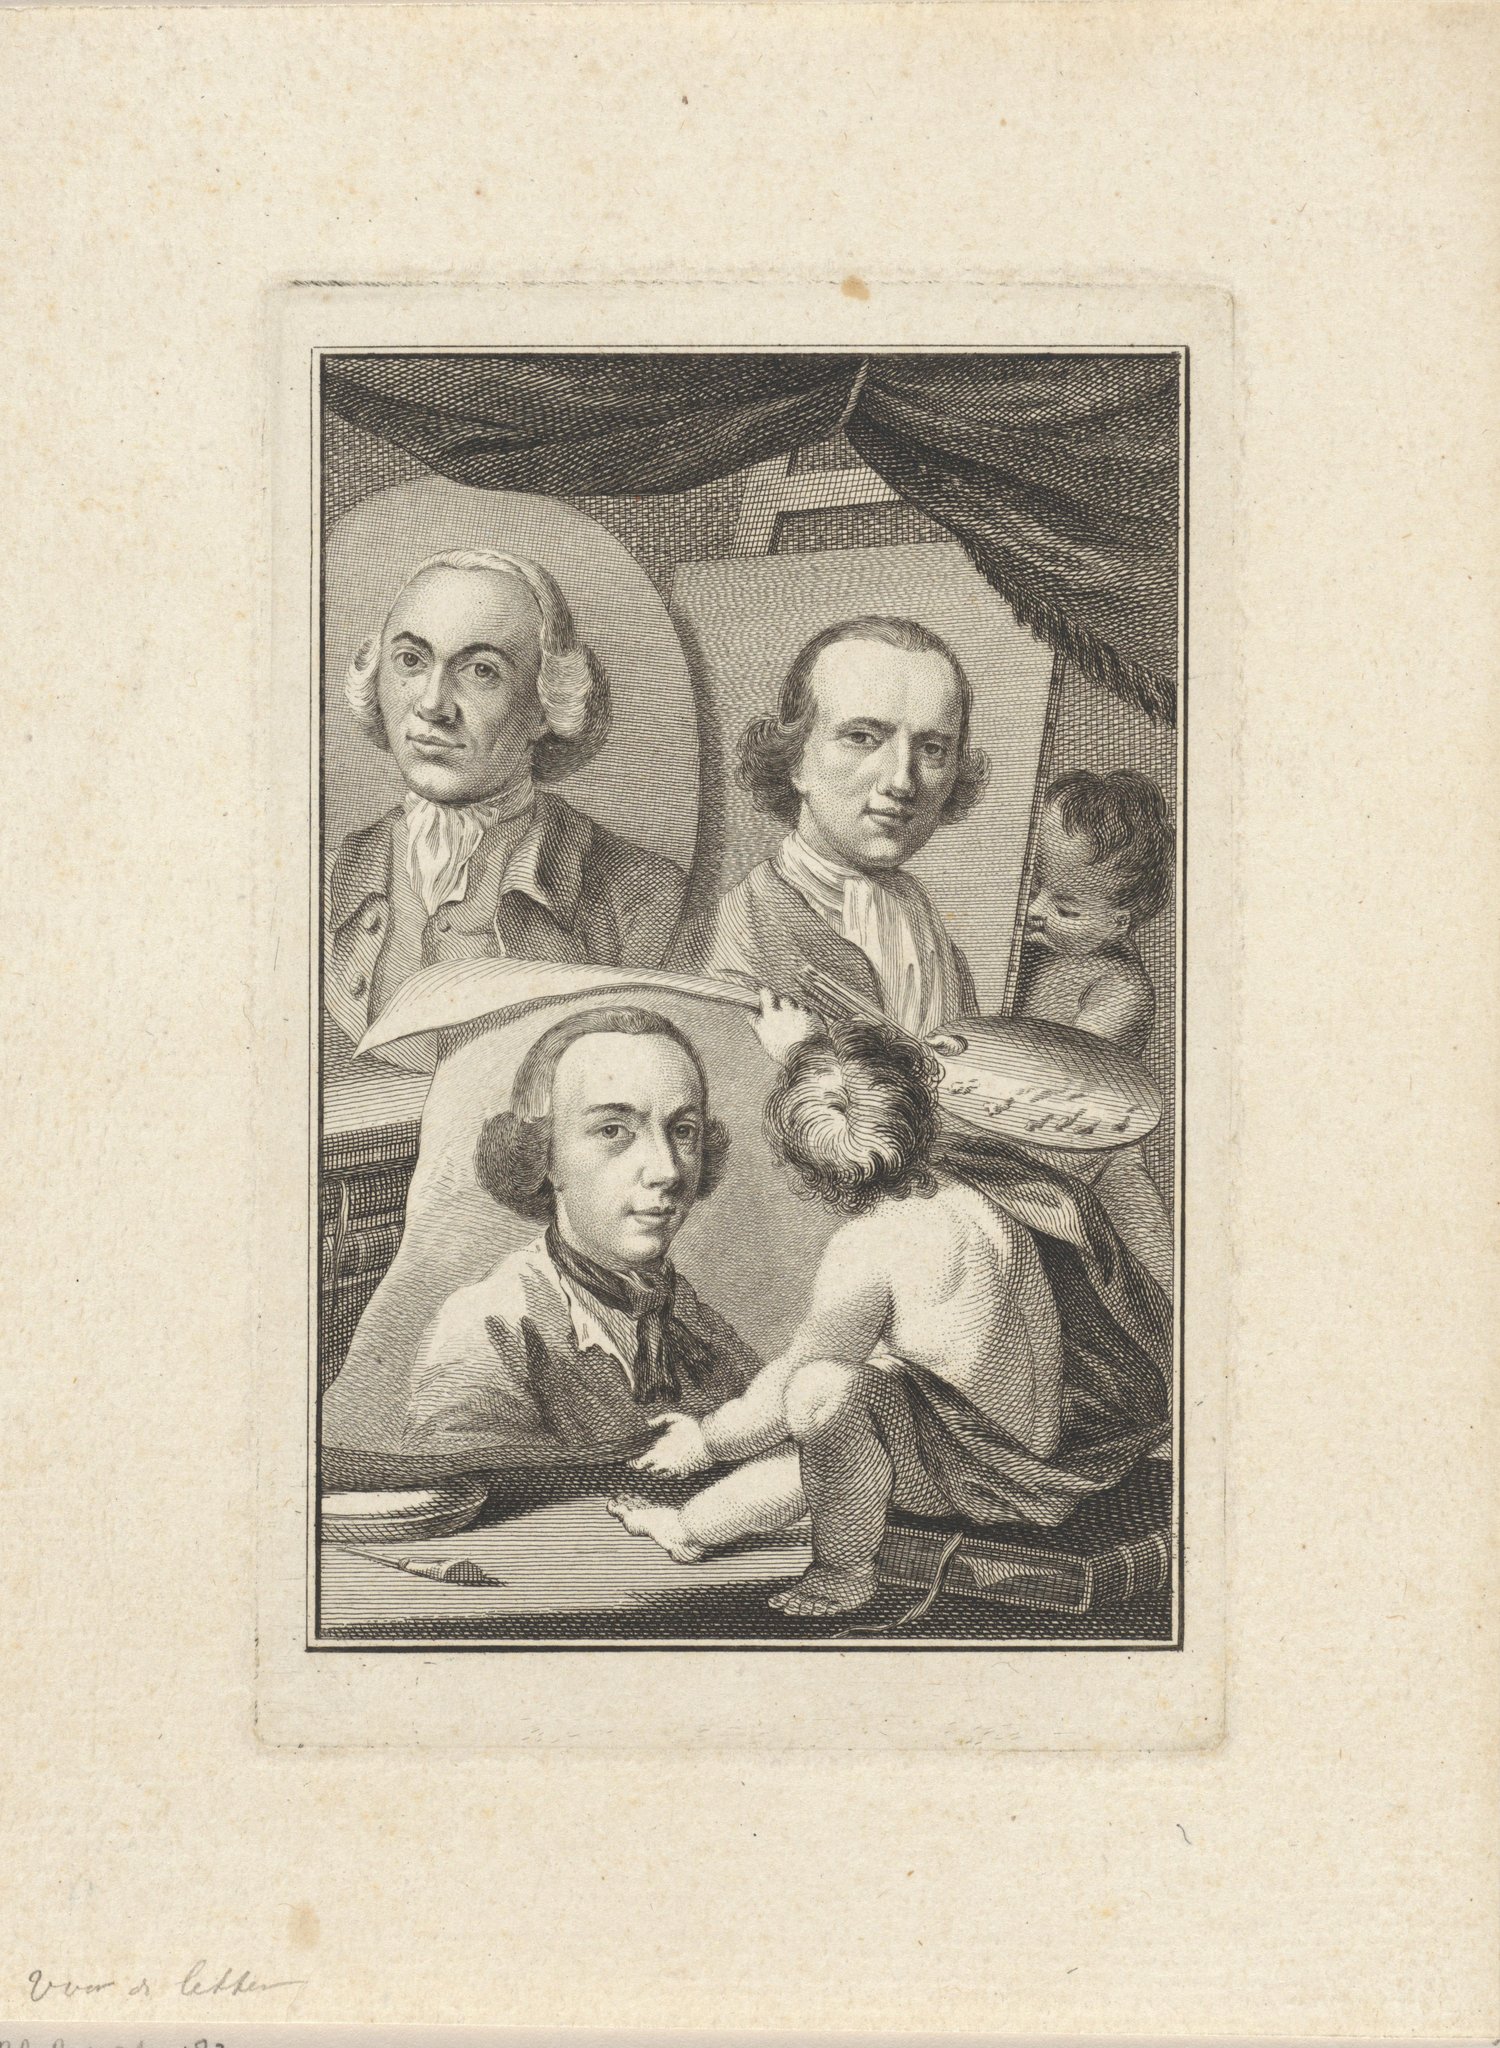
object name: print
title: Portretten van Izaak Schmidt, Jurriaan Andriessen en Reinier Vinkeles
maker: reinier vinkeles (i)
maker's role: draughtsman, print maker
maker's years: 1741-1816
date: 1765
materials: paper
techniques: engraving, etching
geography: amsterdam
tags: amsterdam, painter, draughtsman, jurriaan andriessen, izaak schmidt, print maker, reinier vinkeles (i), palette, cupids: 'amores', 'amoretti', 'putti'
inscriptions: collector's mark: Lugt 2228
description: Twee putti bij de portretten van de kunstenaars Izaak Schmidt, Jurriaan Andriessen en Reinier Vinkeles.